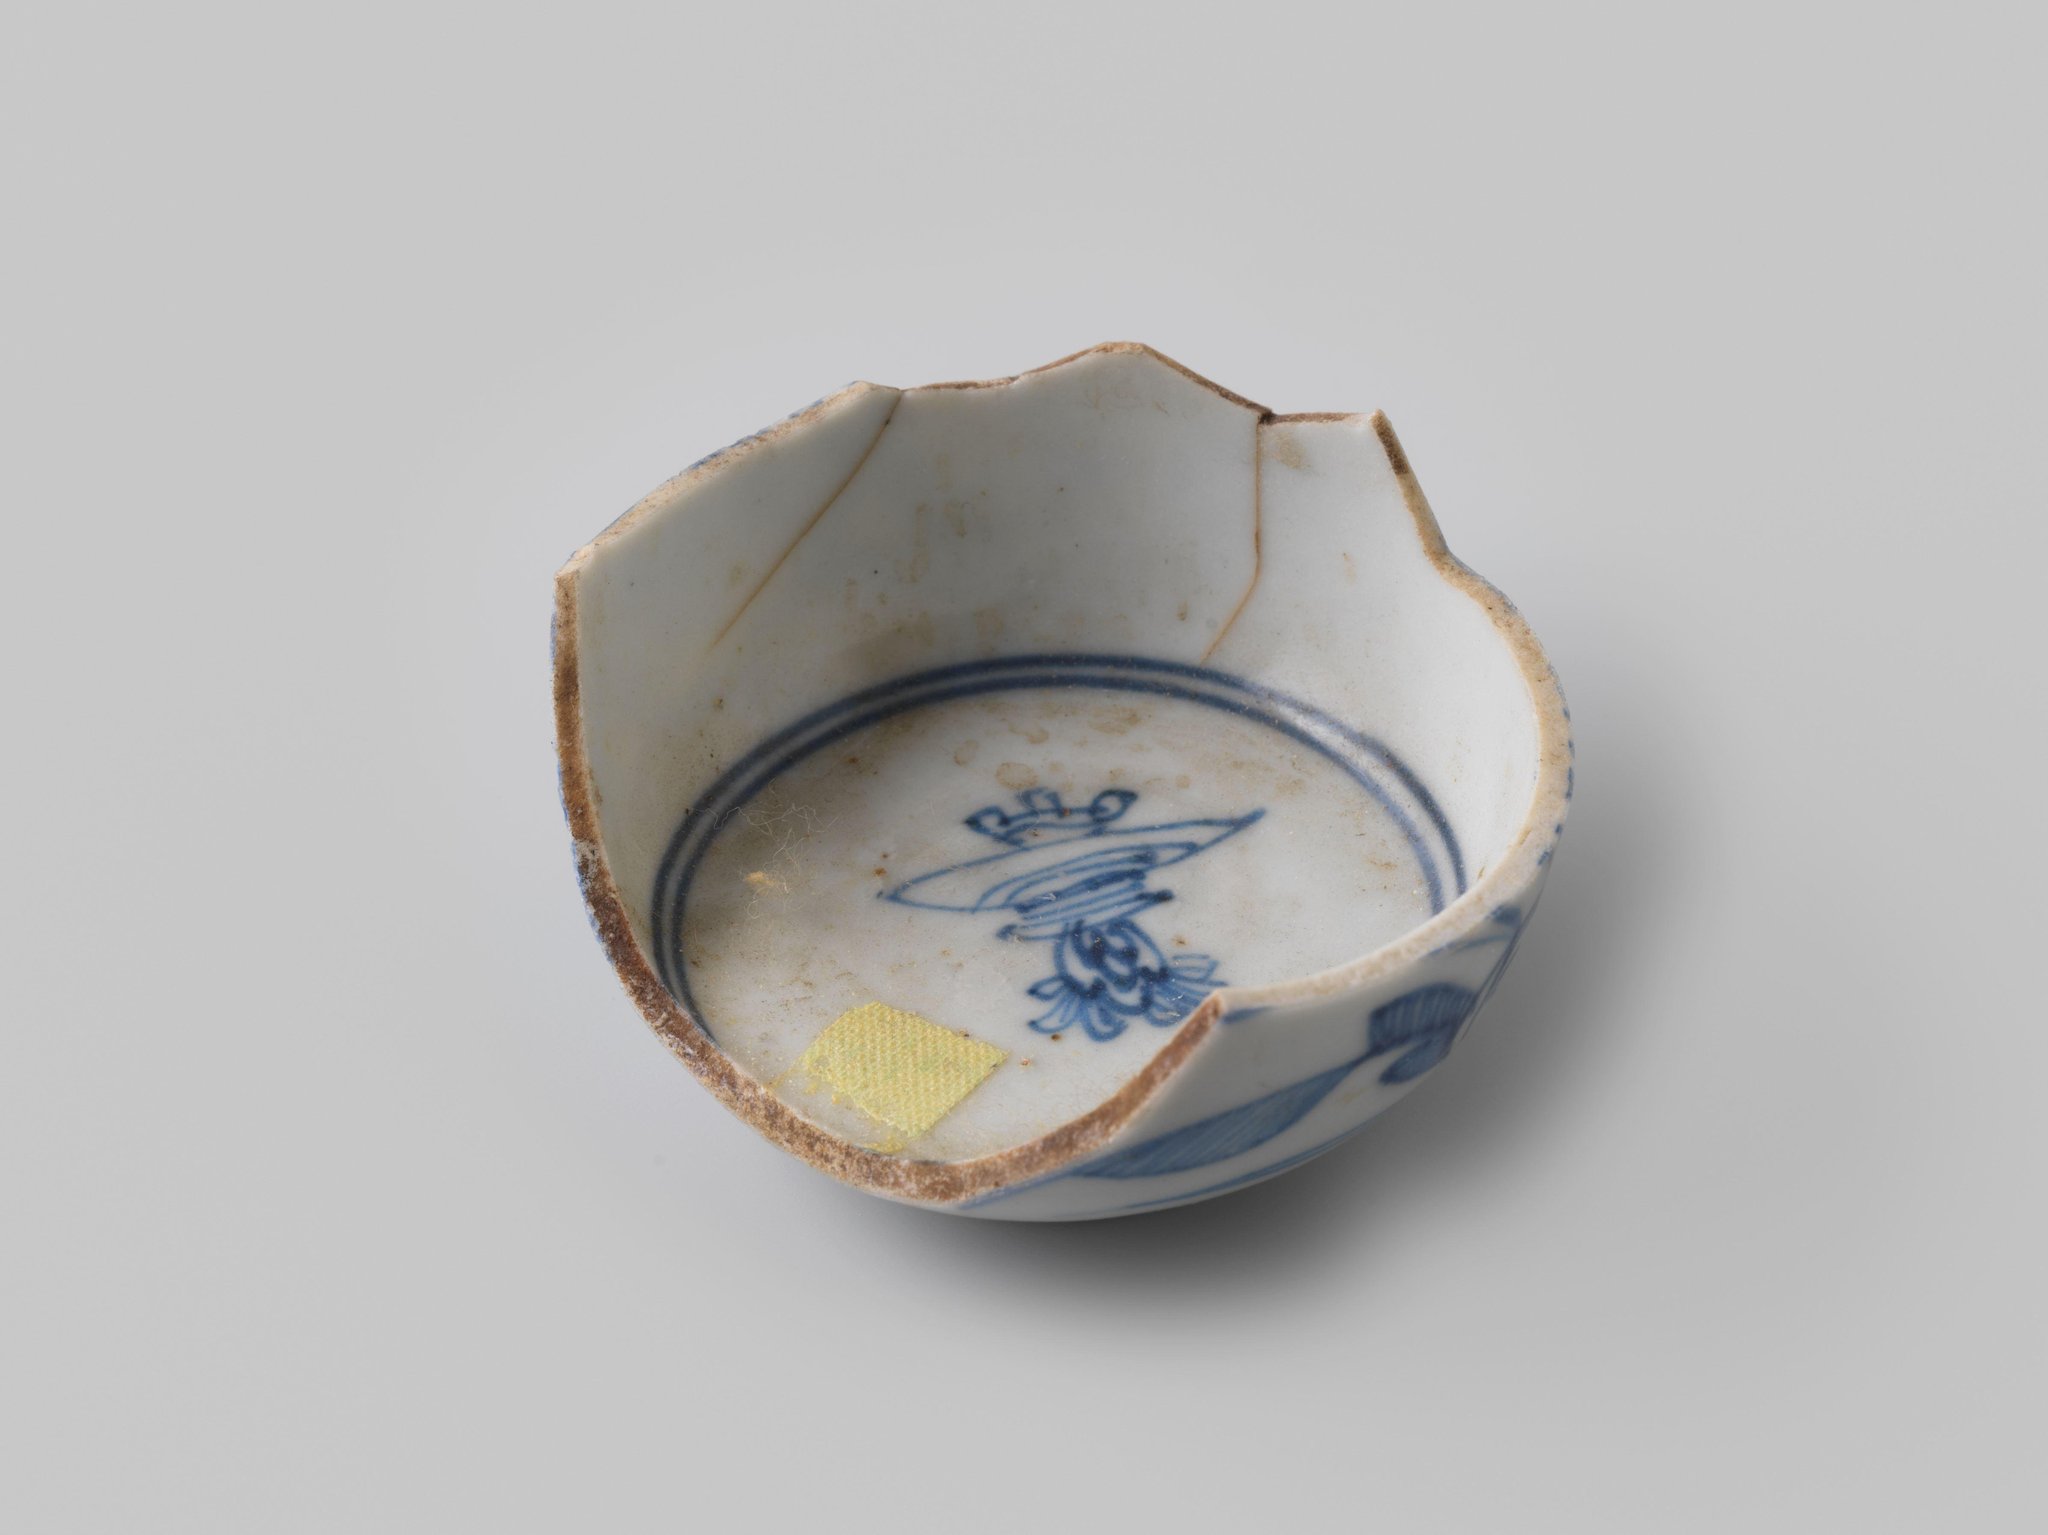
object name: sherd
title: Fragment kom uit V.O.C.-schip de 'Witte Leeuw'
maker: Anonymous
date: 1613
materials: porcelain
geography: jingdezhen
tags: verenigde oostindische compagnie, sint-helena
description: A tea bowl. The cobalt blue is of a very light blue. In the centre a very sketchy design is drawn, encircled by two thin bands. There is no decoration on the walls. On the outside four carps are sketchily drawn in various poses among waterweed and flowers.